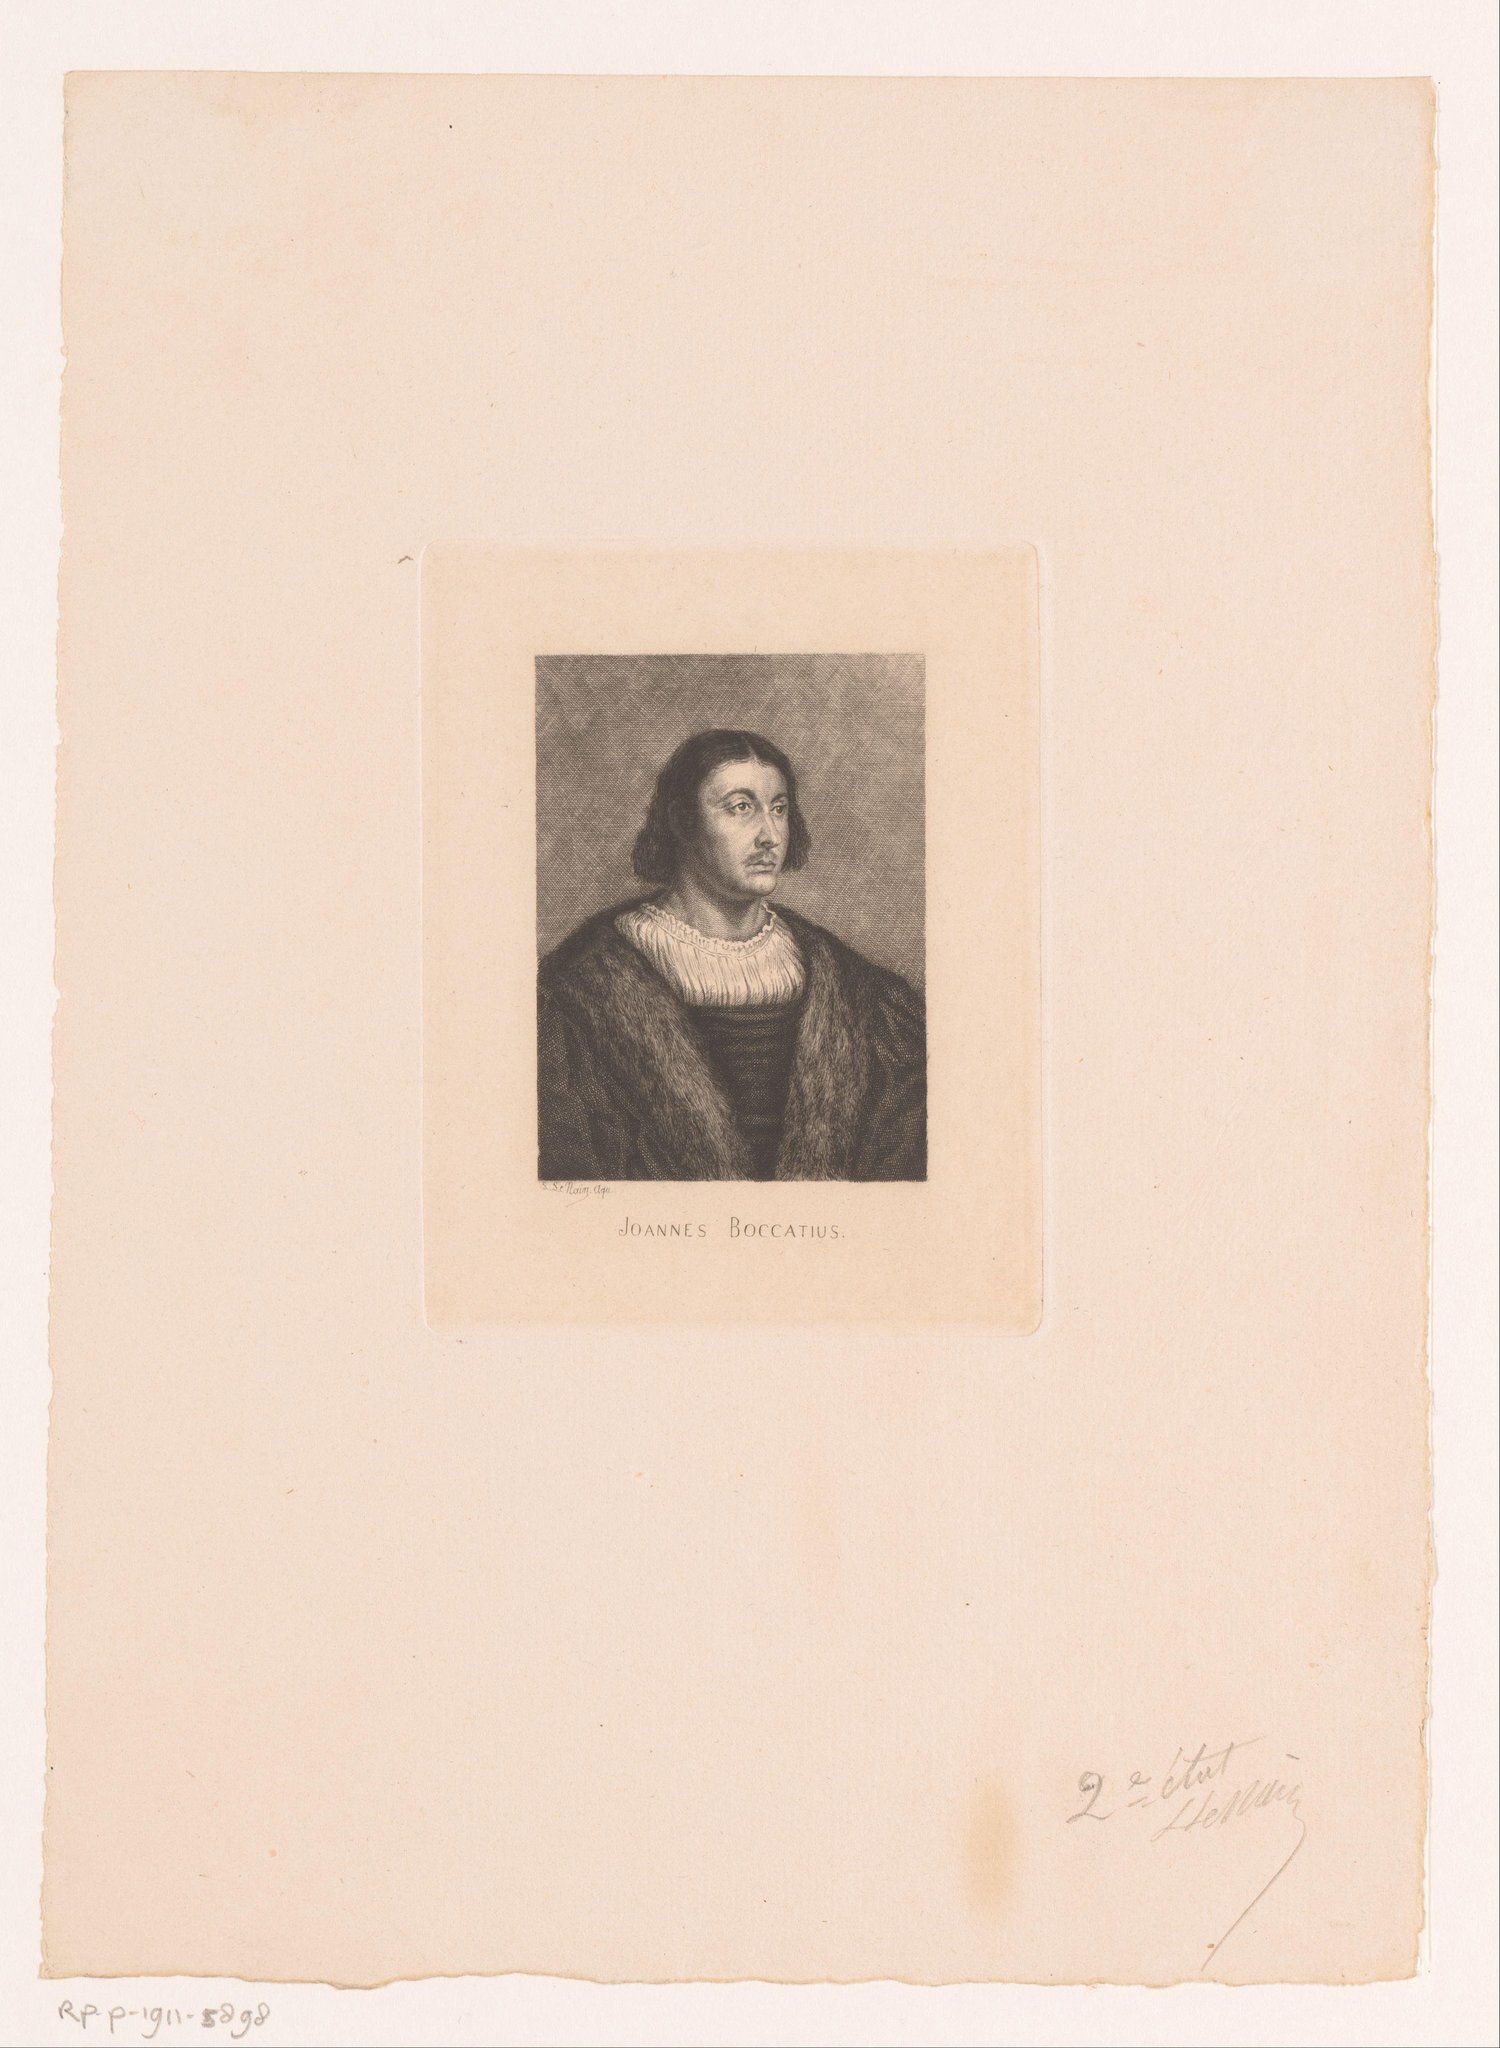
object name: print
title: Joannes Boccatius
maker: louis le nain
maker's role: print maker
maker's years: 1851-1939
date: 1861-1911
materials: paper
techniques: etching, intaglio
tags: giovanni boccaccio, adult man, historical persons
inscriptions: collector's mark: Lugt 2228, inscription: ‘2e état Lle Nain’